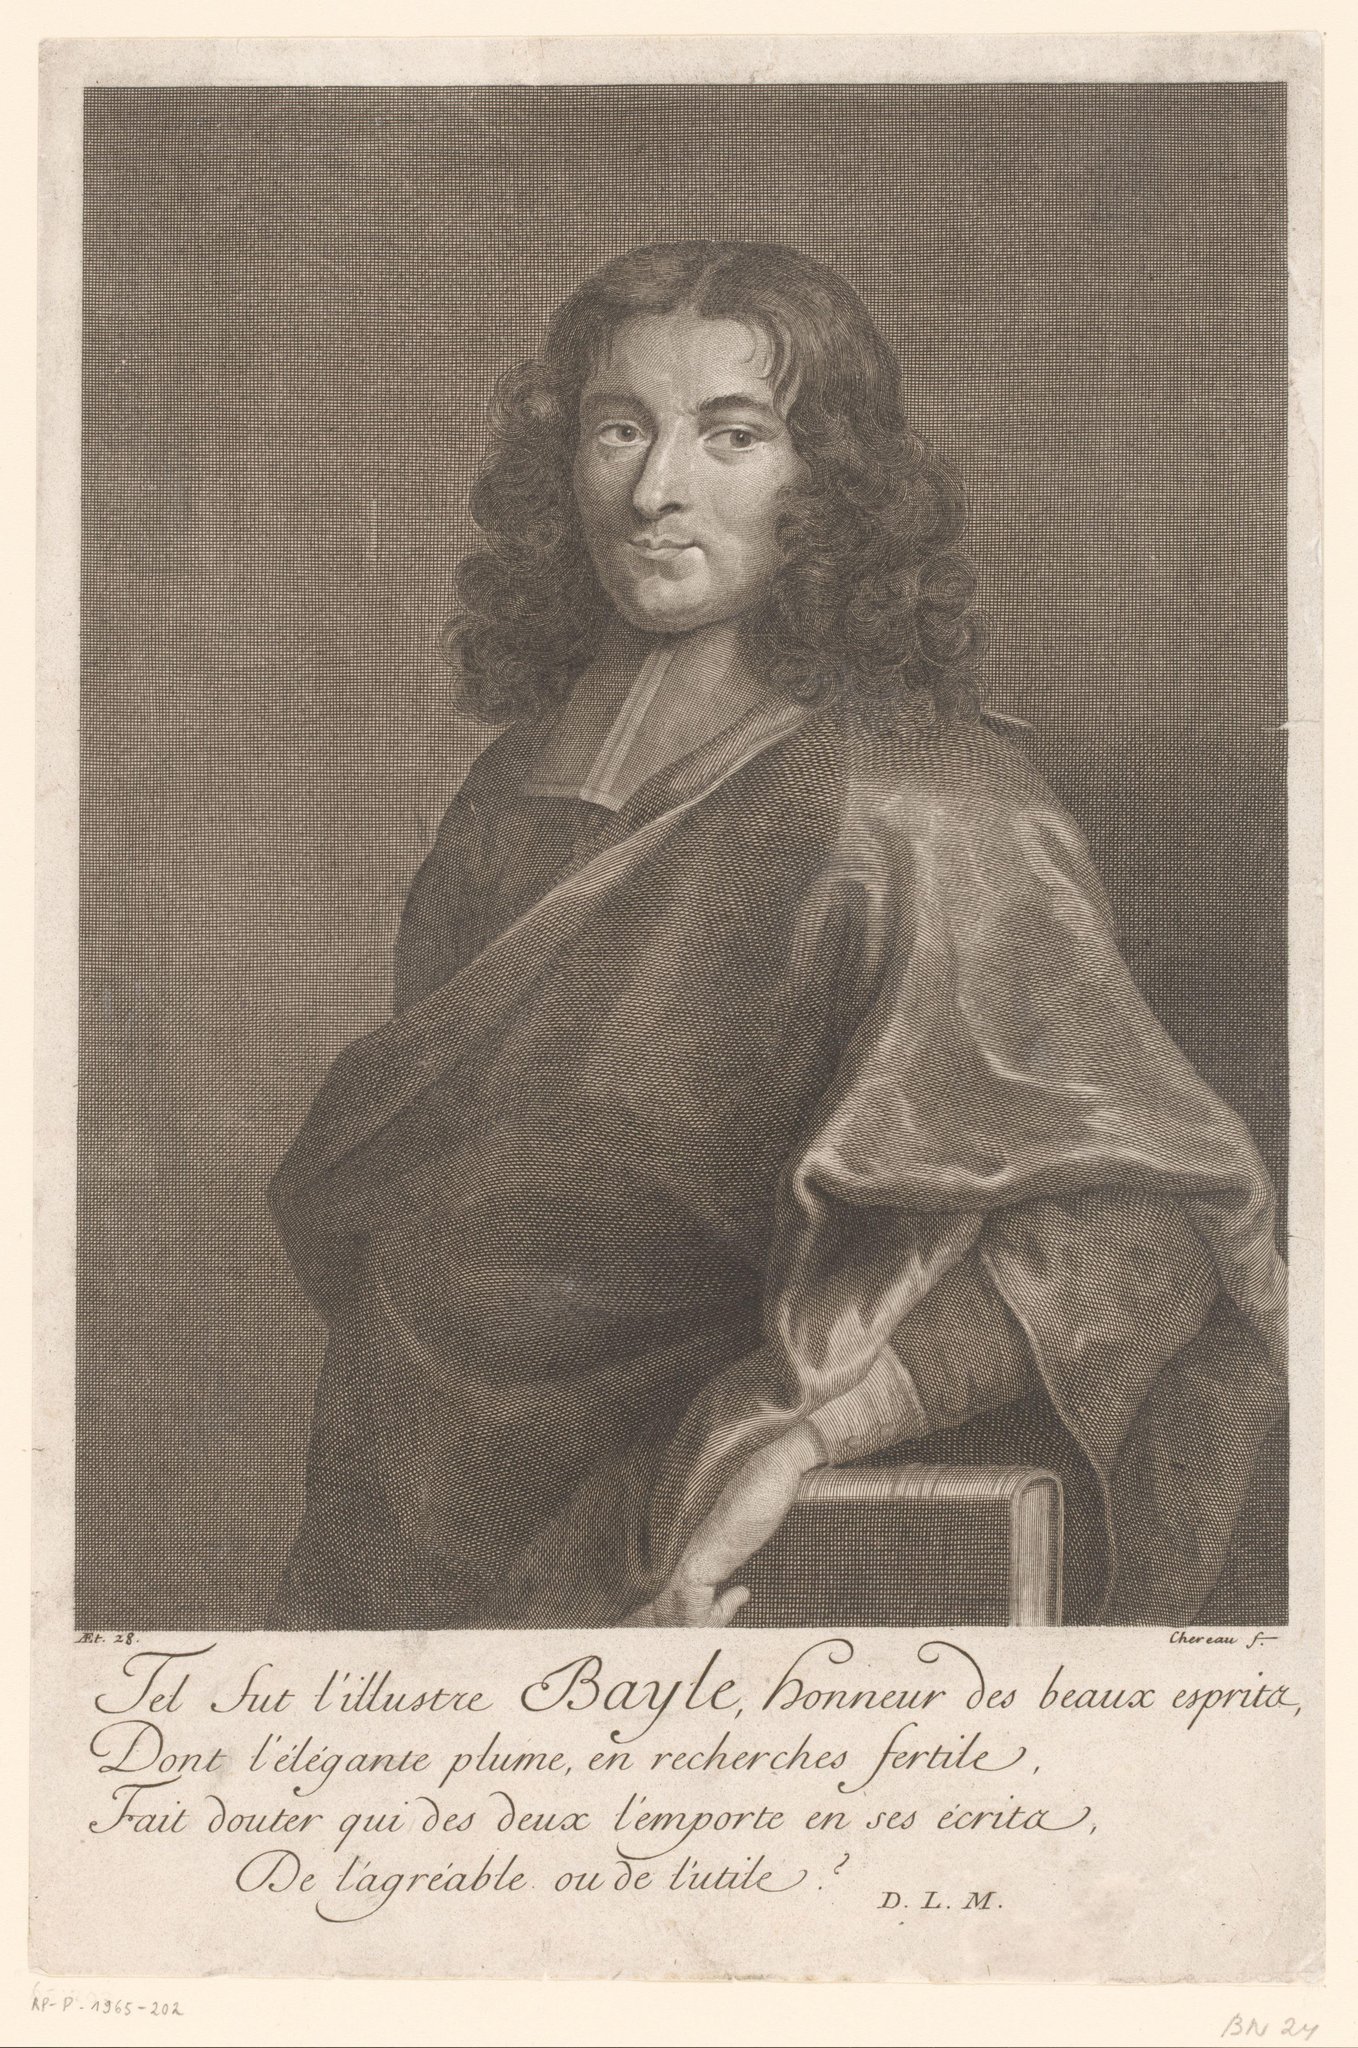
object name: print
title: Portret van Pierre Bayle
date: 1690-1729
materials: paper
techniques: engraving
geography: france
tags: historical persons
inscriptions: collector's mark: Lugt 2228, collector's mark: Lugt 2760